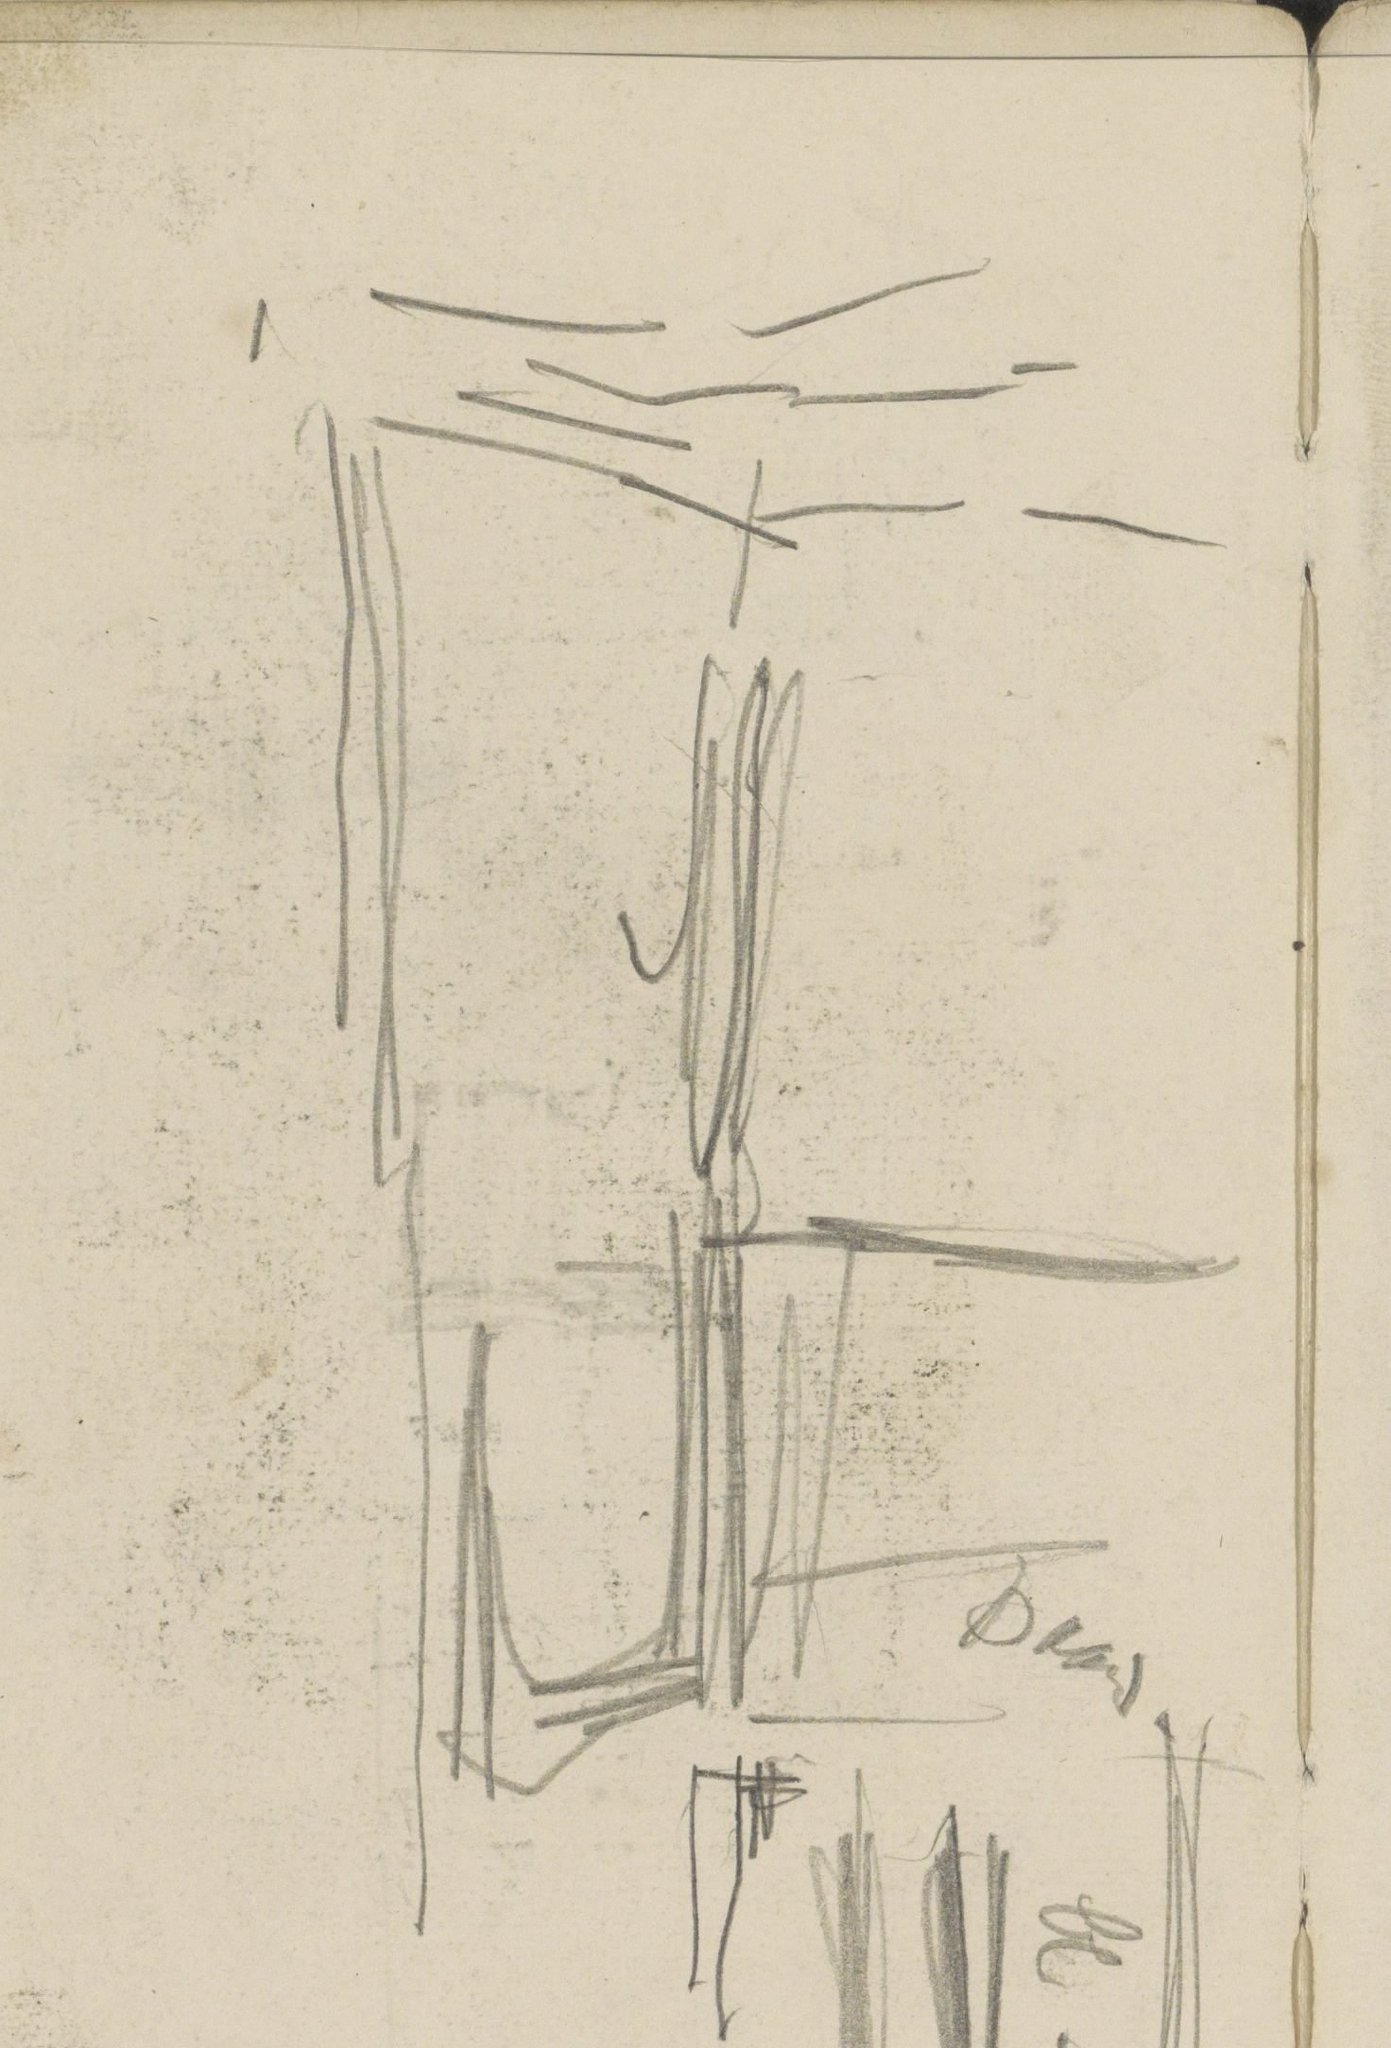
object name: sketchbook leaf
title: Architectuurstudie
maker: george hendrik breitner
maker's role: draughtsman, painter, print maker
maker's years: 1857-1923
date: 1886-1923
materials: paper, pencil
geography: amsterdam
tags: architecture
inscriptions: kleurnotitie, handgeschreven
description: Pagina 53 uit een schetsboek met 19 bladen en 9 losse tekeningen.